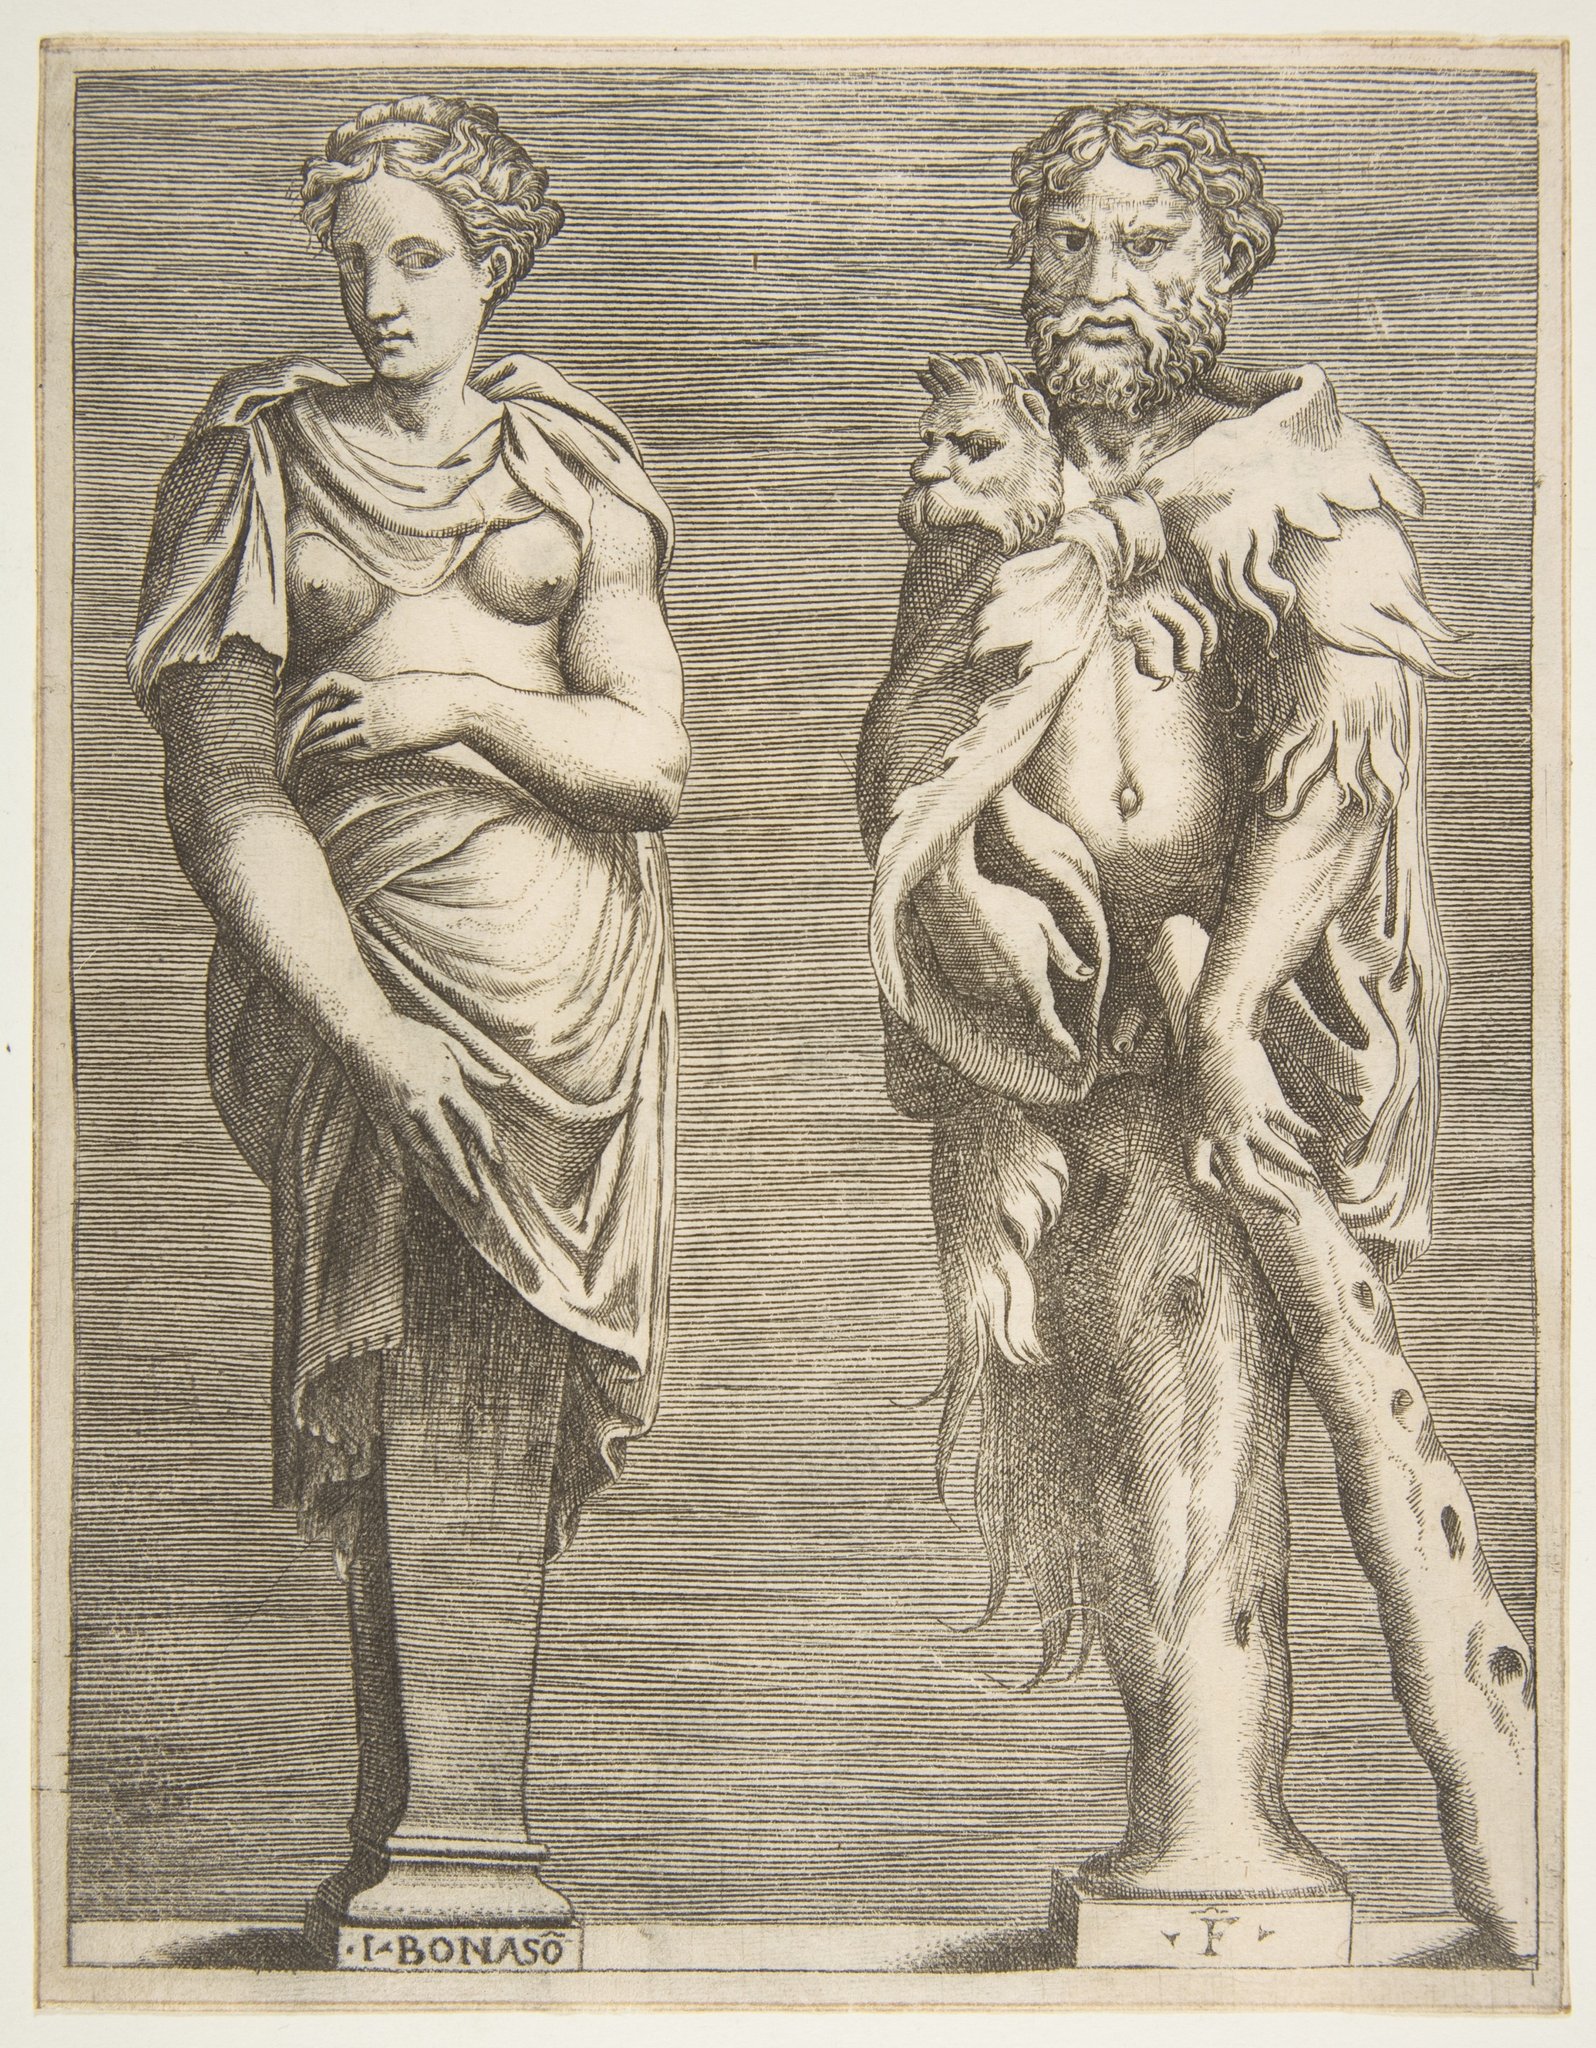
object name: print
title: Terms of Hercules and Deianira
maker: giulio bonasone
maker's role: artist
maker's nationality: italian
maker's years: 1510-1576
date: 1531-1576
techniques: engraving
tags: female nudes,hercules